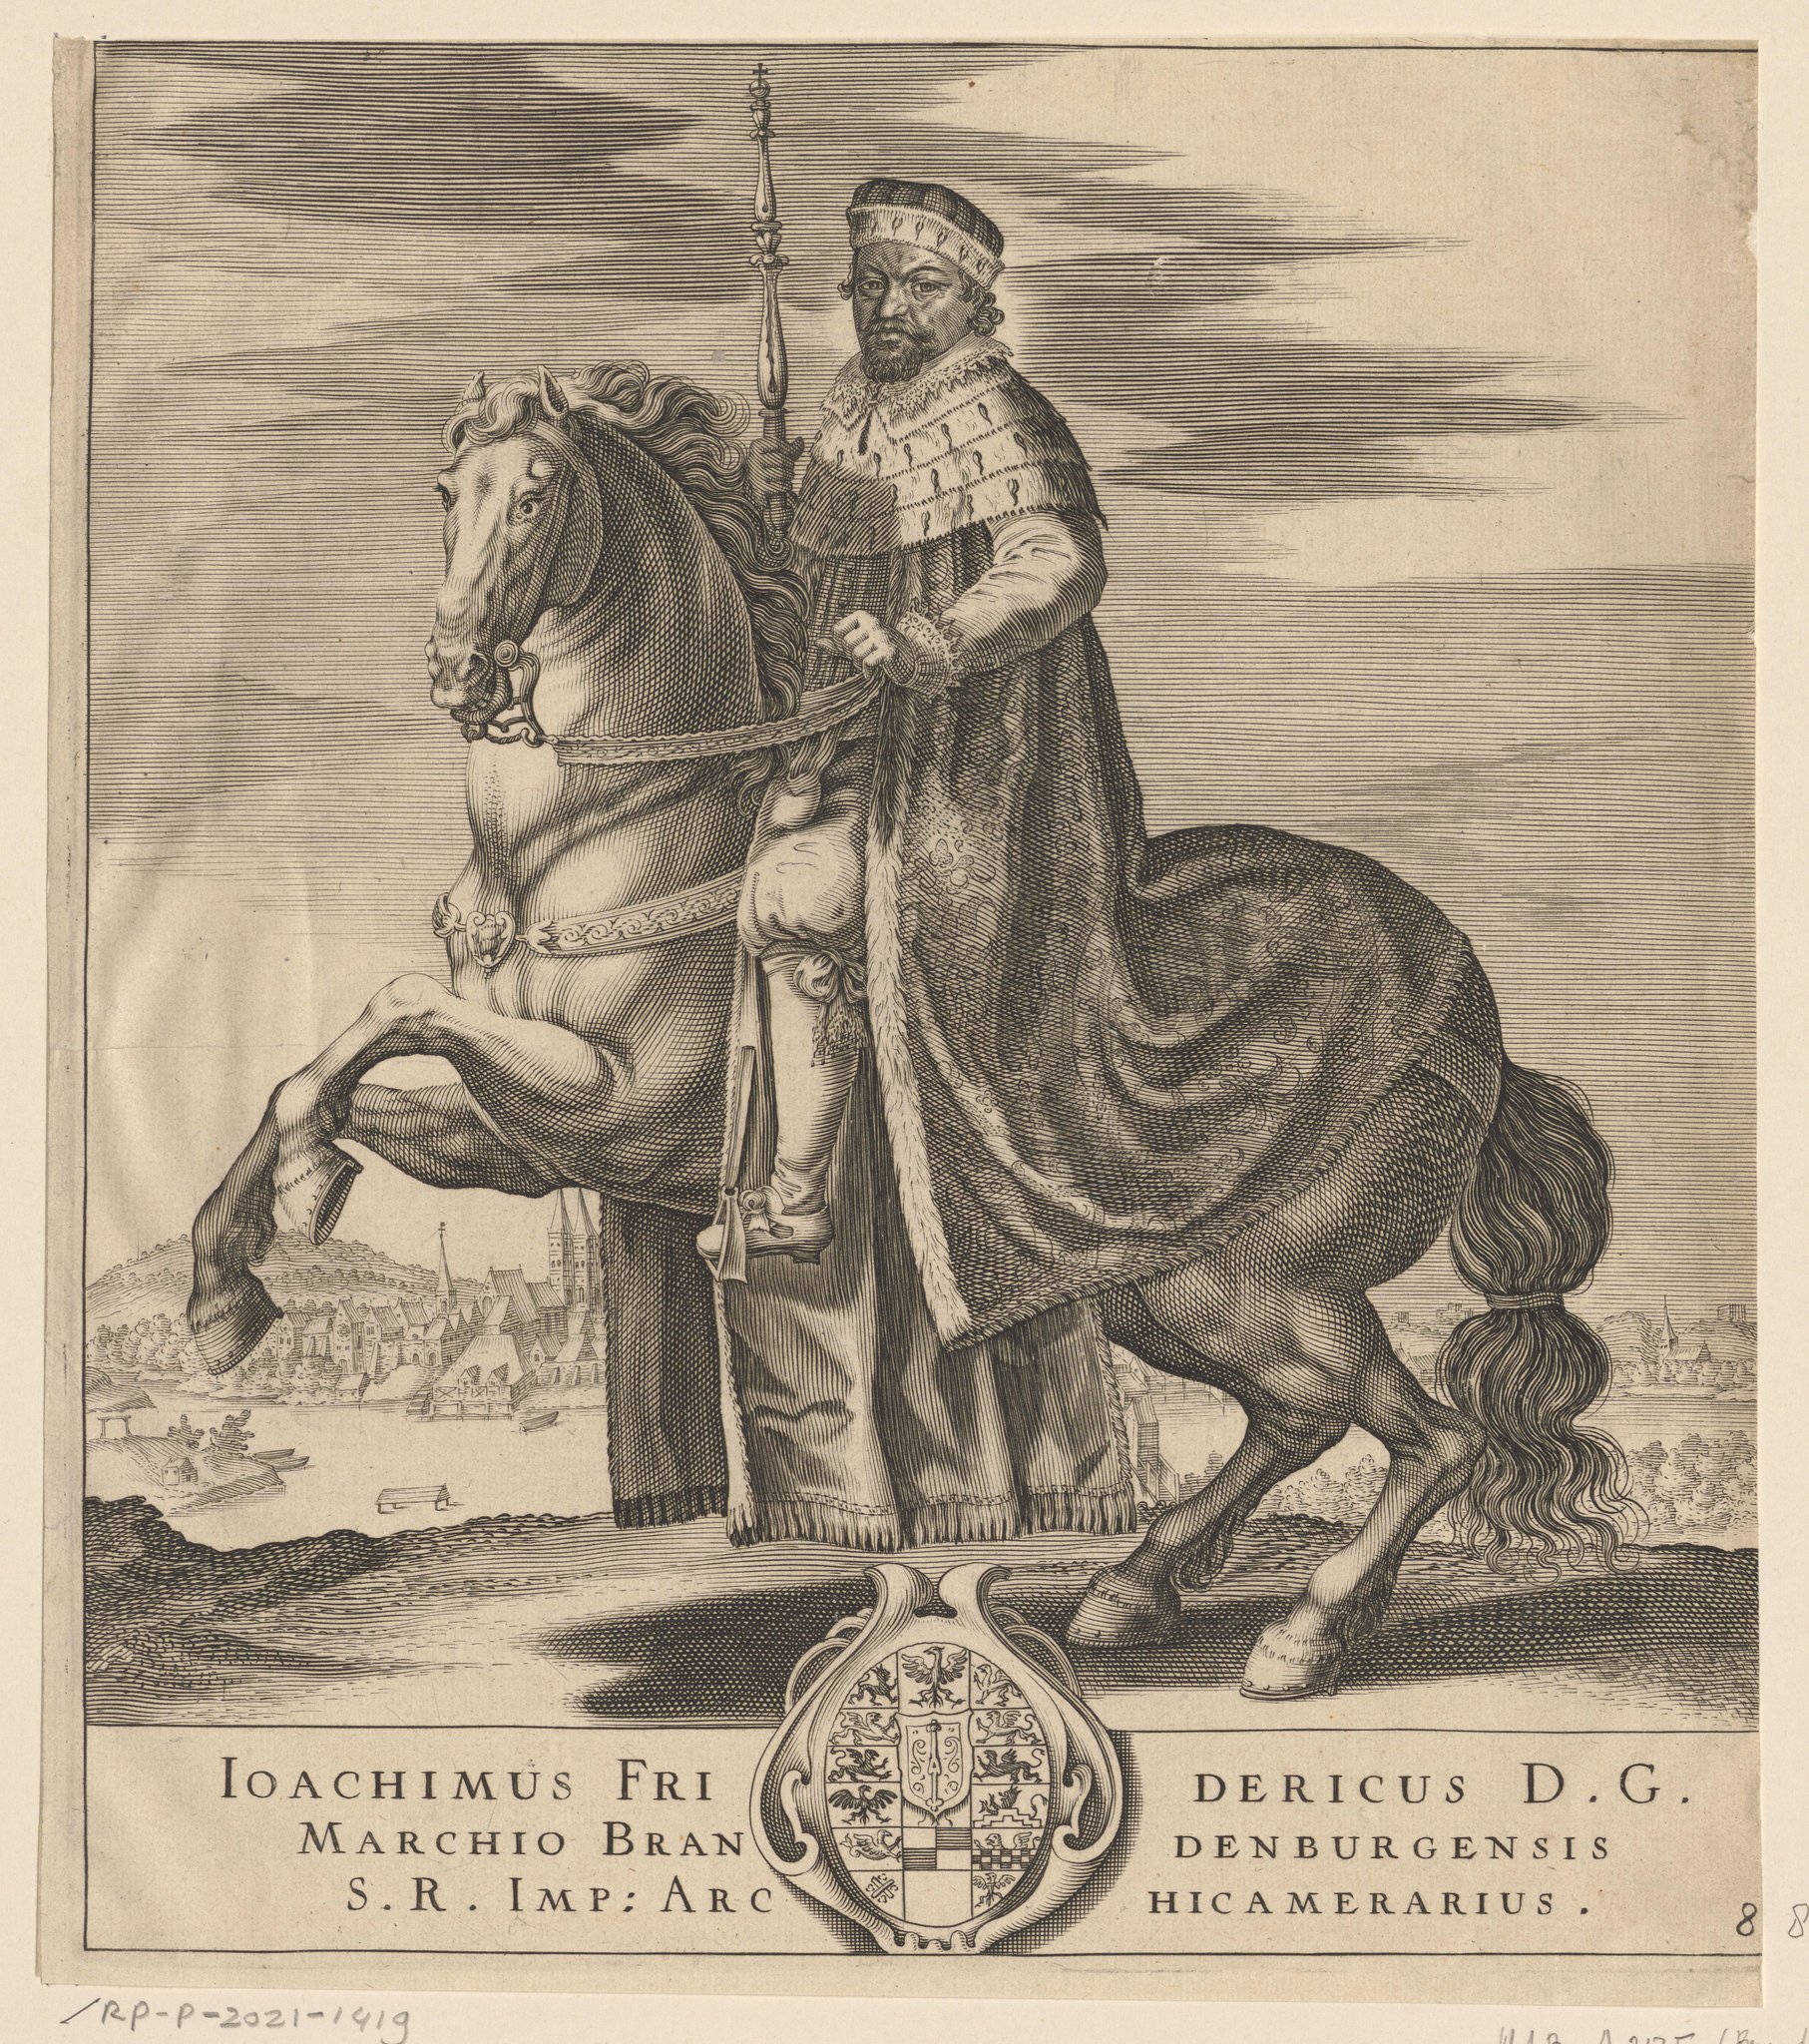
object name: print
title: Ruiterportret van Joachim Frederik van Brandenburg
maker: Anonymous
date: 1600-1699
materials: paper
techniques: engraving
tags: berlin, equestrian state-portrait, historical persons, ruler, sovereign, armorial bearing, heraldry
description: Met onder het portret zijn wapenschild. Rechtsonder genummerd: 8.